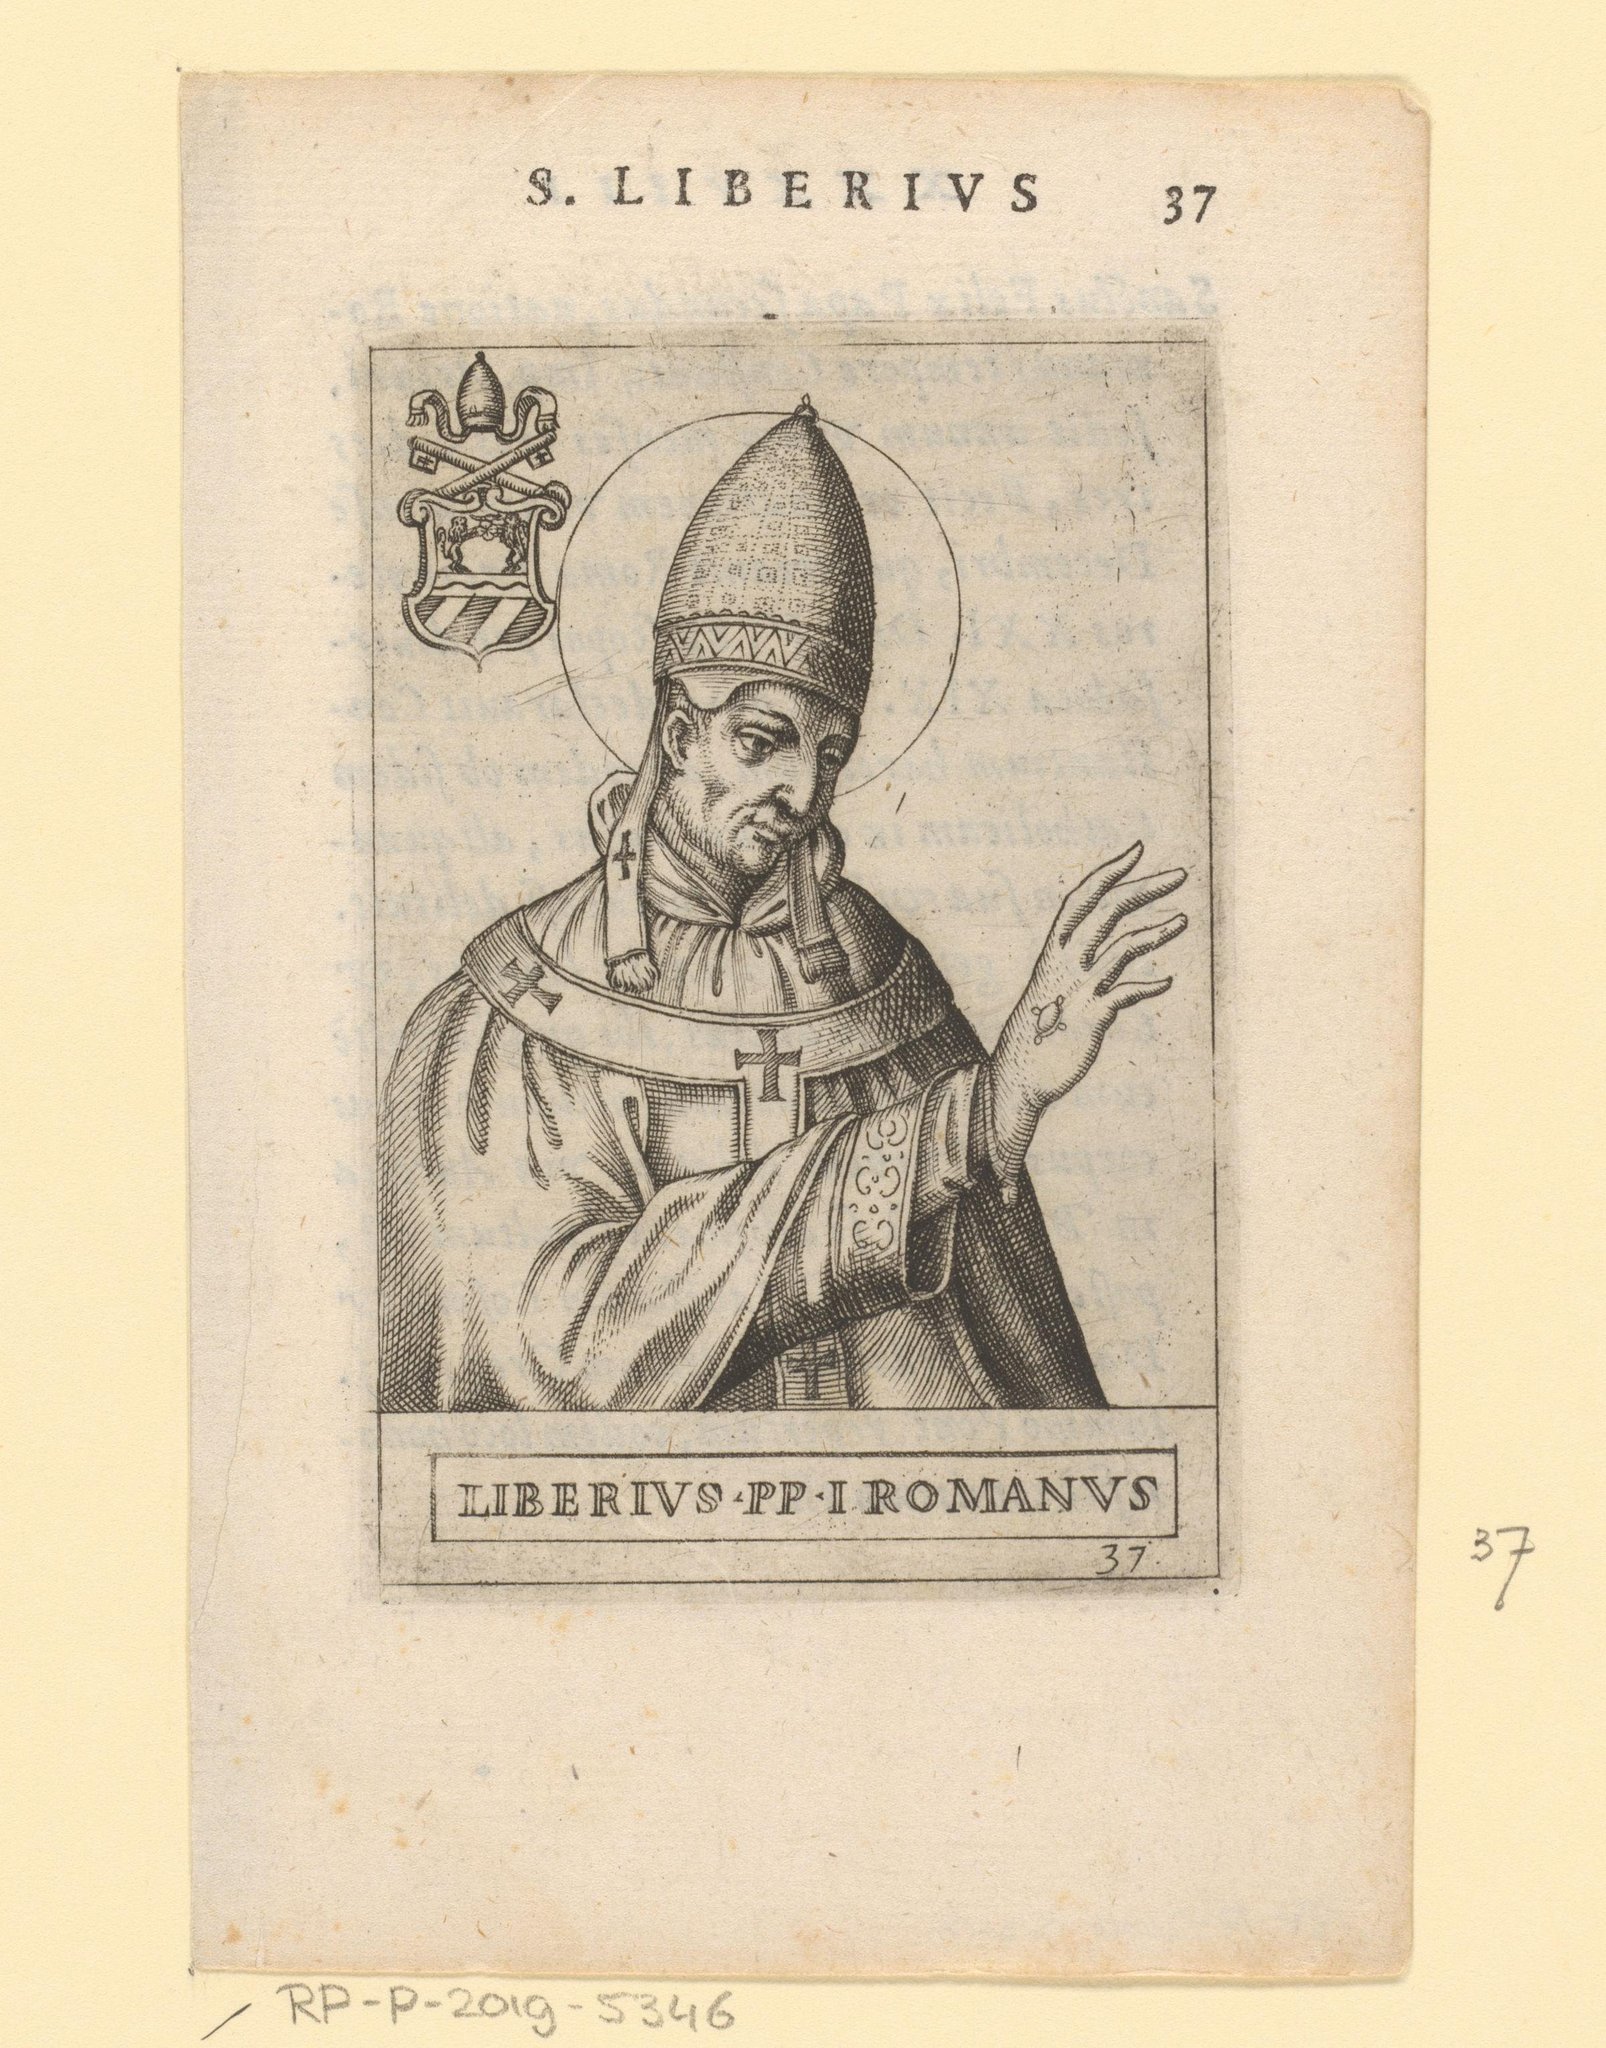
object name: book illustration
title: Liberius PP I Romanus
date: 1595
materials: paper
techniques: engraving, letterpress printing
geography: rome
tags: historical persons, pope, armorial bearing, heraldry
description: Prent uit: Cavalieri, Giovanni Battista de'. Effigies pontificum romanorum cum eorum vitis (...). Rome: Bartolomeo Bonfadino, 1595. Prent voor het eerst verschenen in: Cavalieri, Giovanni Battista de'. Pontificum romanorum effigies (...). Rome: Domenico Basa en Francesco Zanetti, 1580. Prent ook gebruikt in latere publicaties.